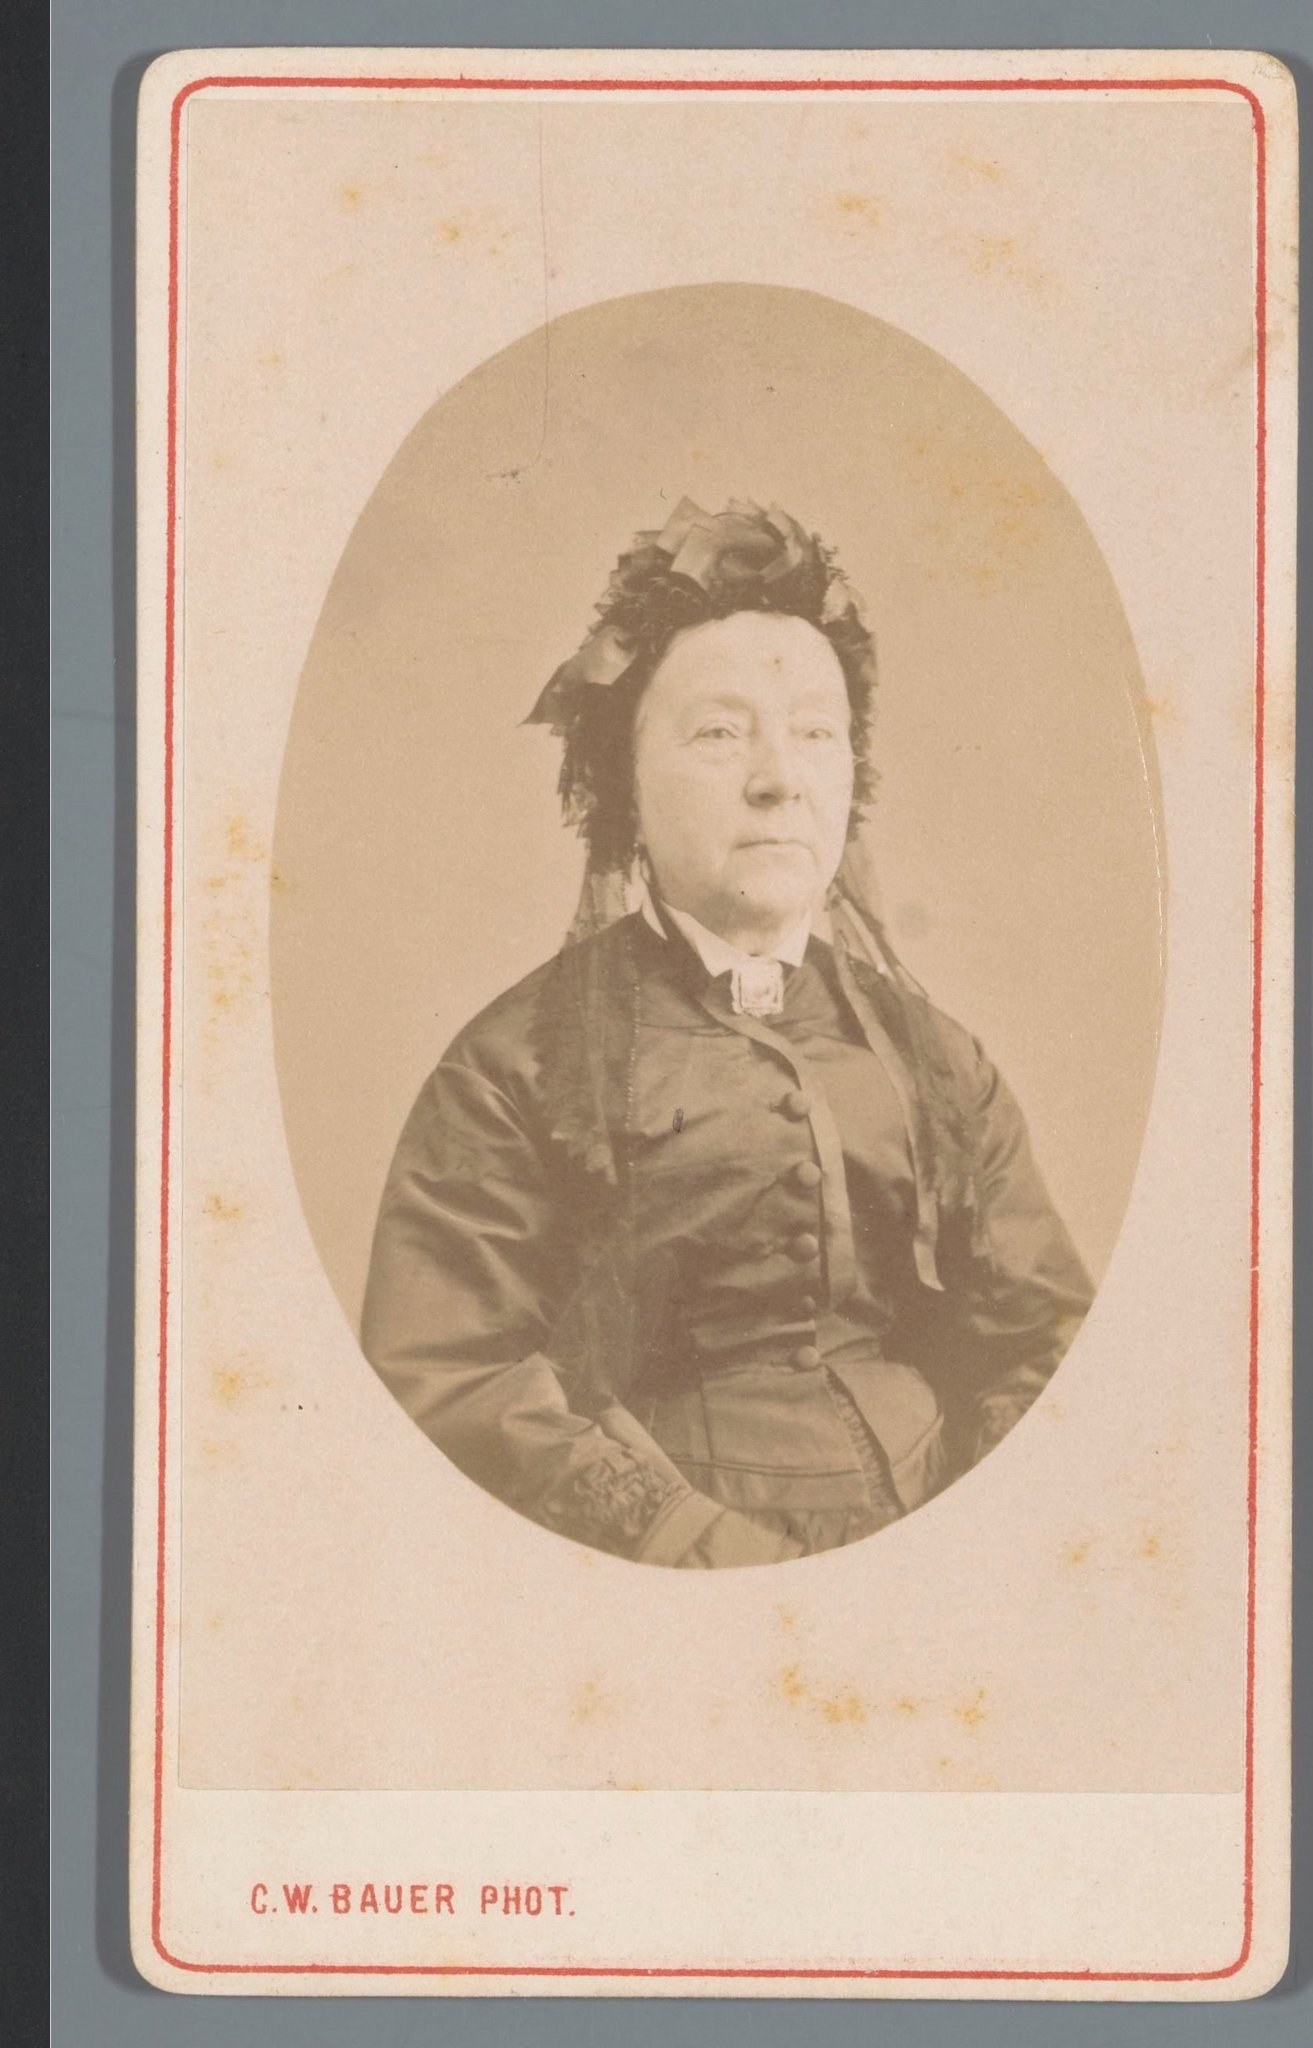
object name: semi enamel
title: Portret van een onbekende vrouw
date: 1880-1908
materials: cardboard, celluloid, paper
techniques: albumen print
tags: historical persons - bb - woman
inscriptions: inscription: ‘PHOTOGR. CWB ATELIER/ C. W. BAUER/ Photographe/ MIDDELBURG/ en/ GOES.’